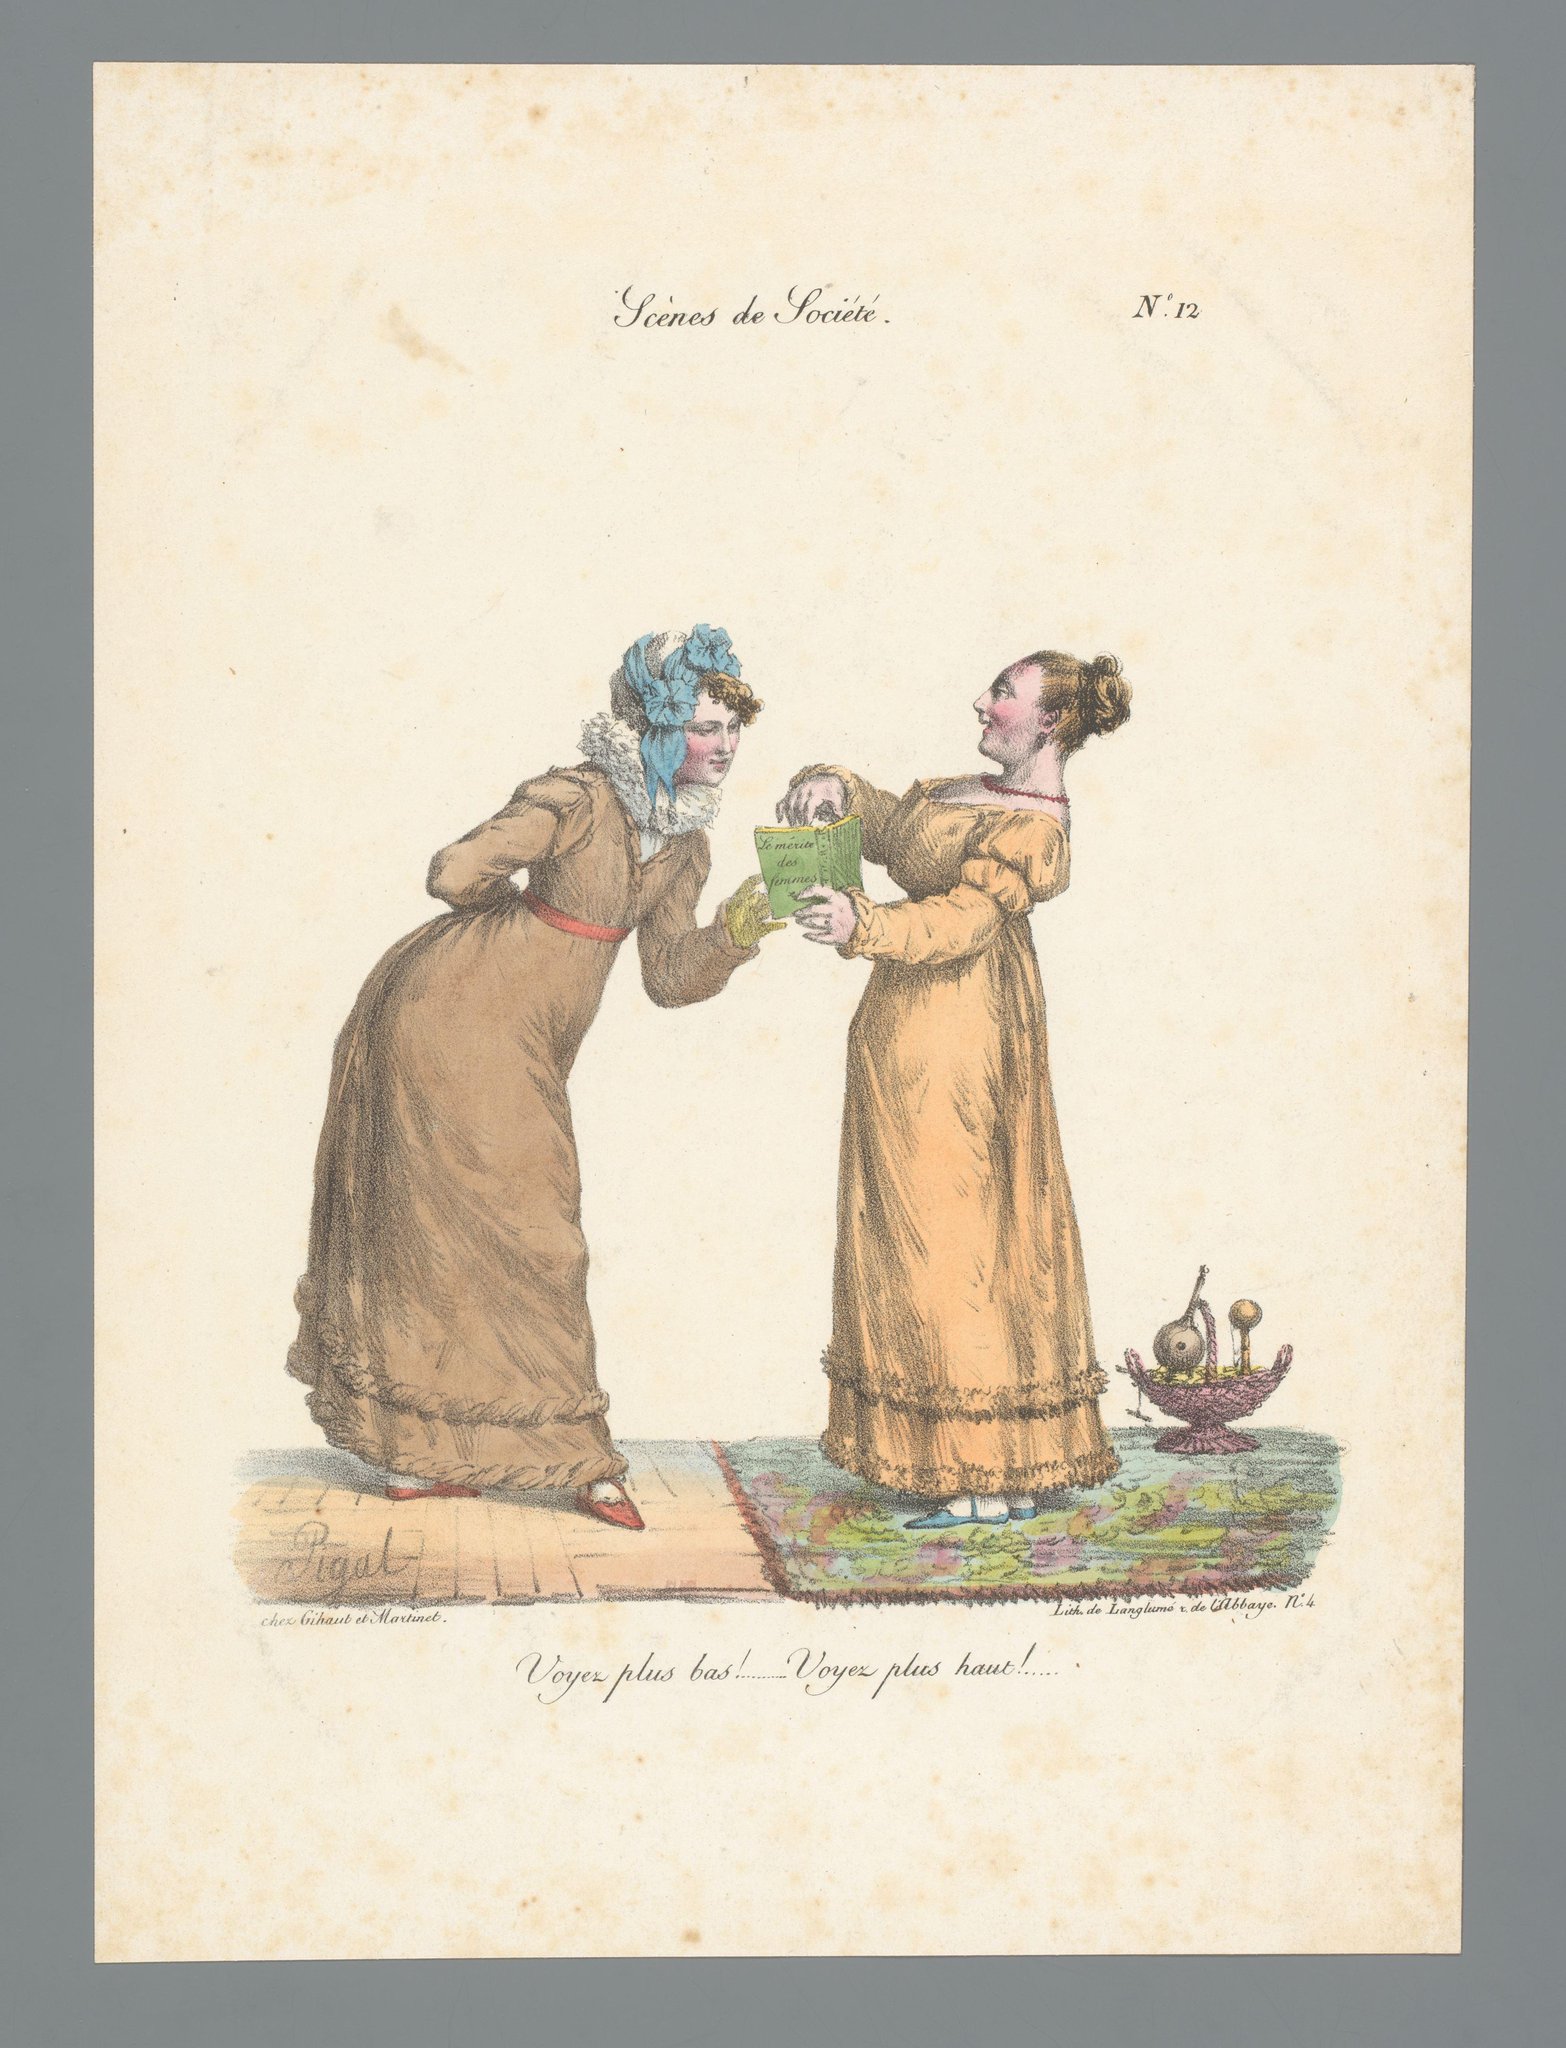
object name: print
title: Scènes de société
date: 1822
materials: paper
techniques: hand coloring, lithograph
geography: paris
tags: adult woman, book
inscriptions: collector's mark: Lugt 2228